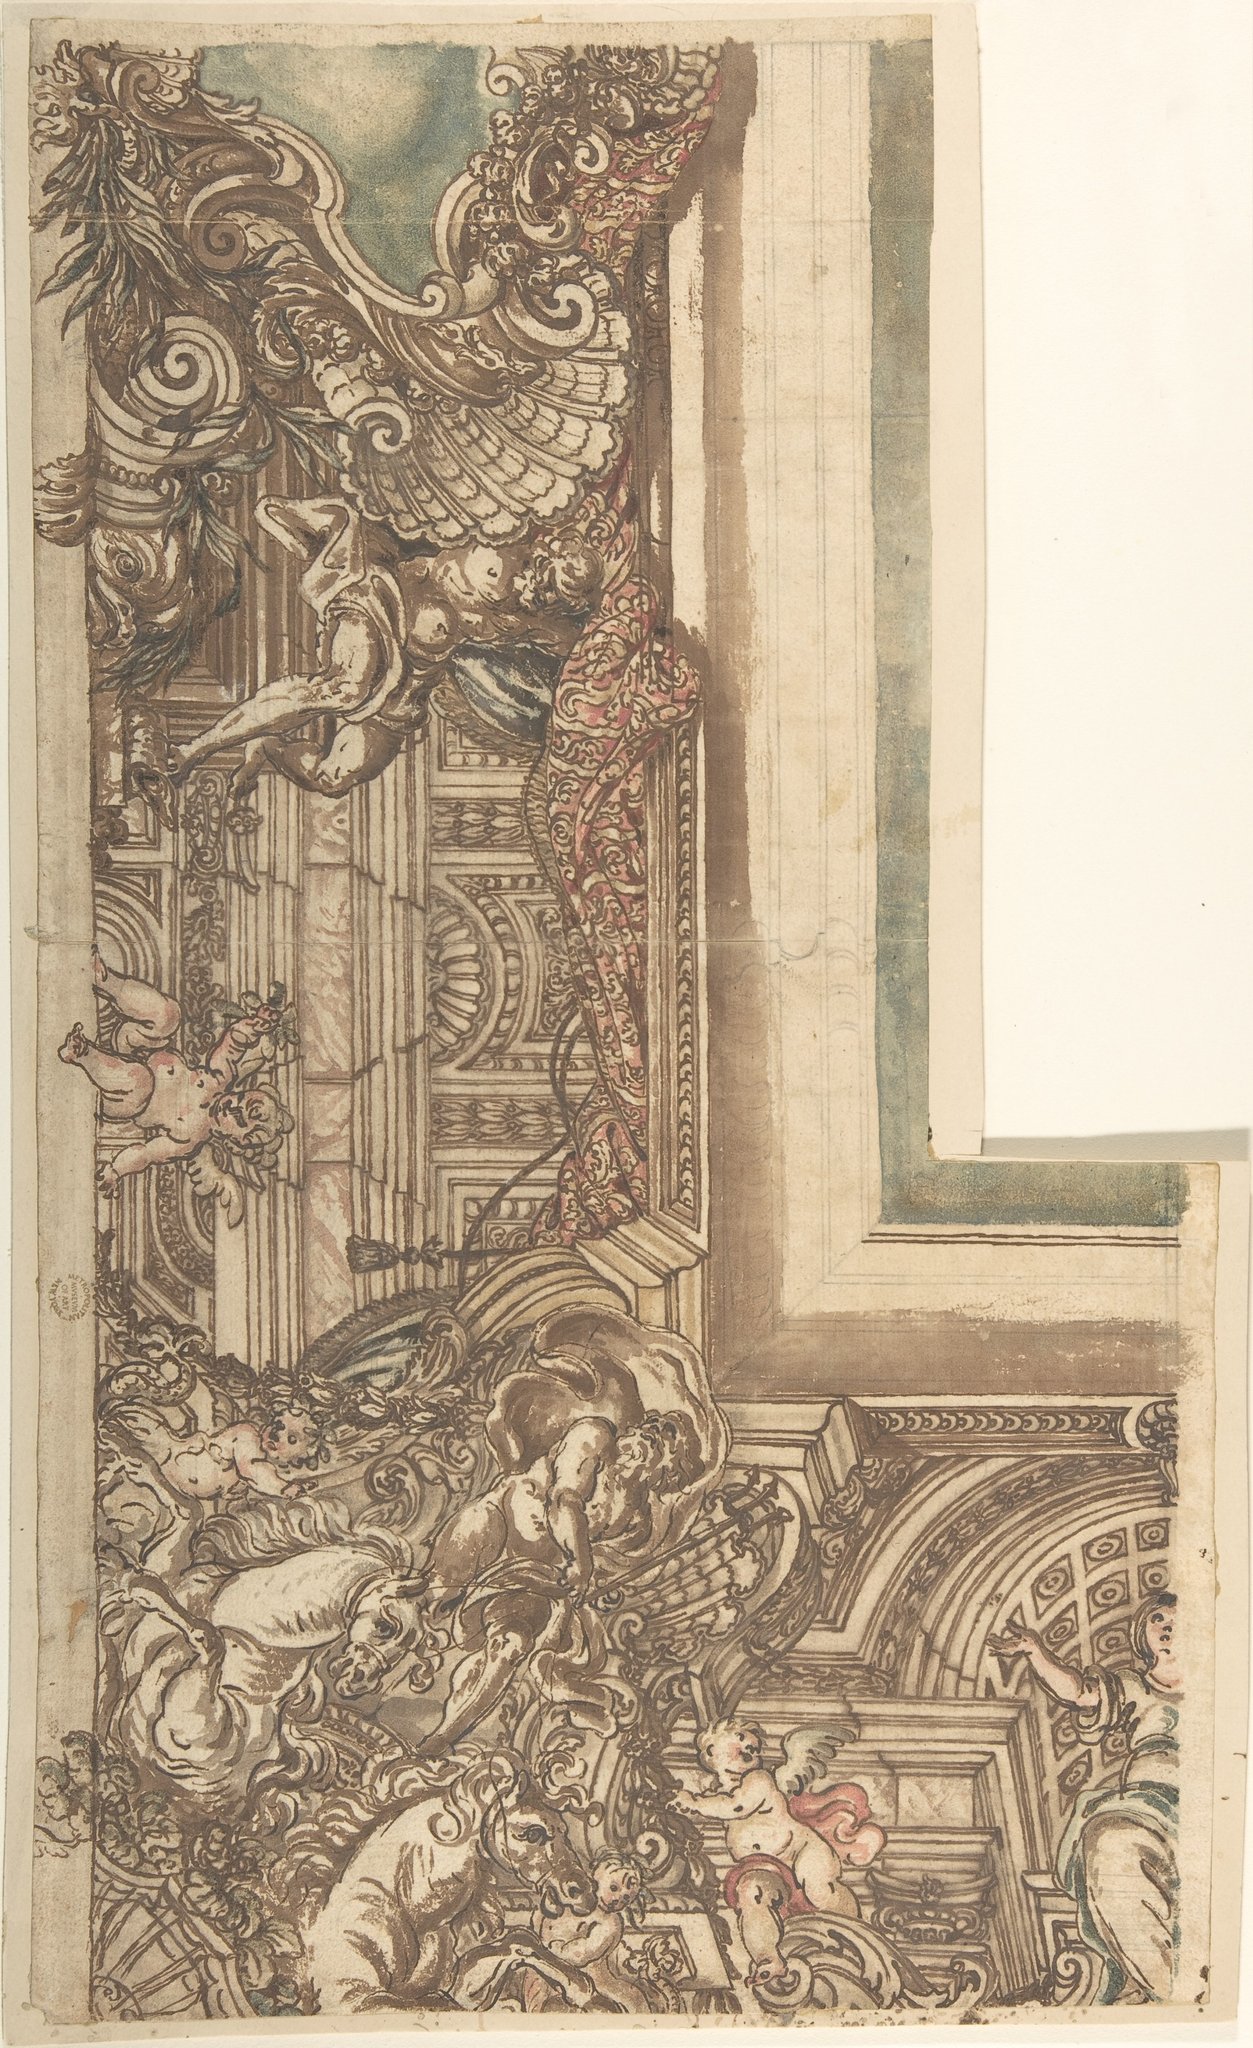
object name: drawing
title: Ceiling Design with Neptune in Corner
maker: anonymous, italian, 17th century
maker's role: artist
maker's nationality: italian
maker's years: 1600-1700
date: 1601-1700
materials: ink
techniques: pen, wash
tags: ornament,neptune,horses